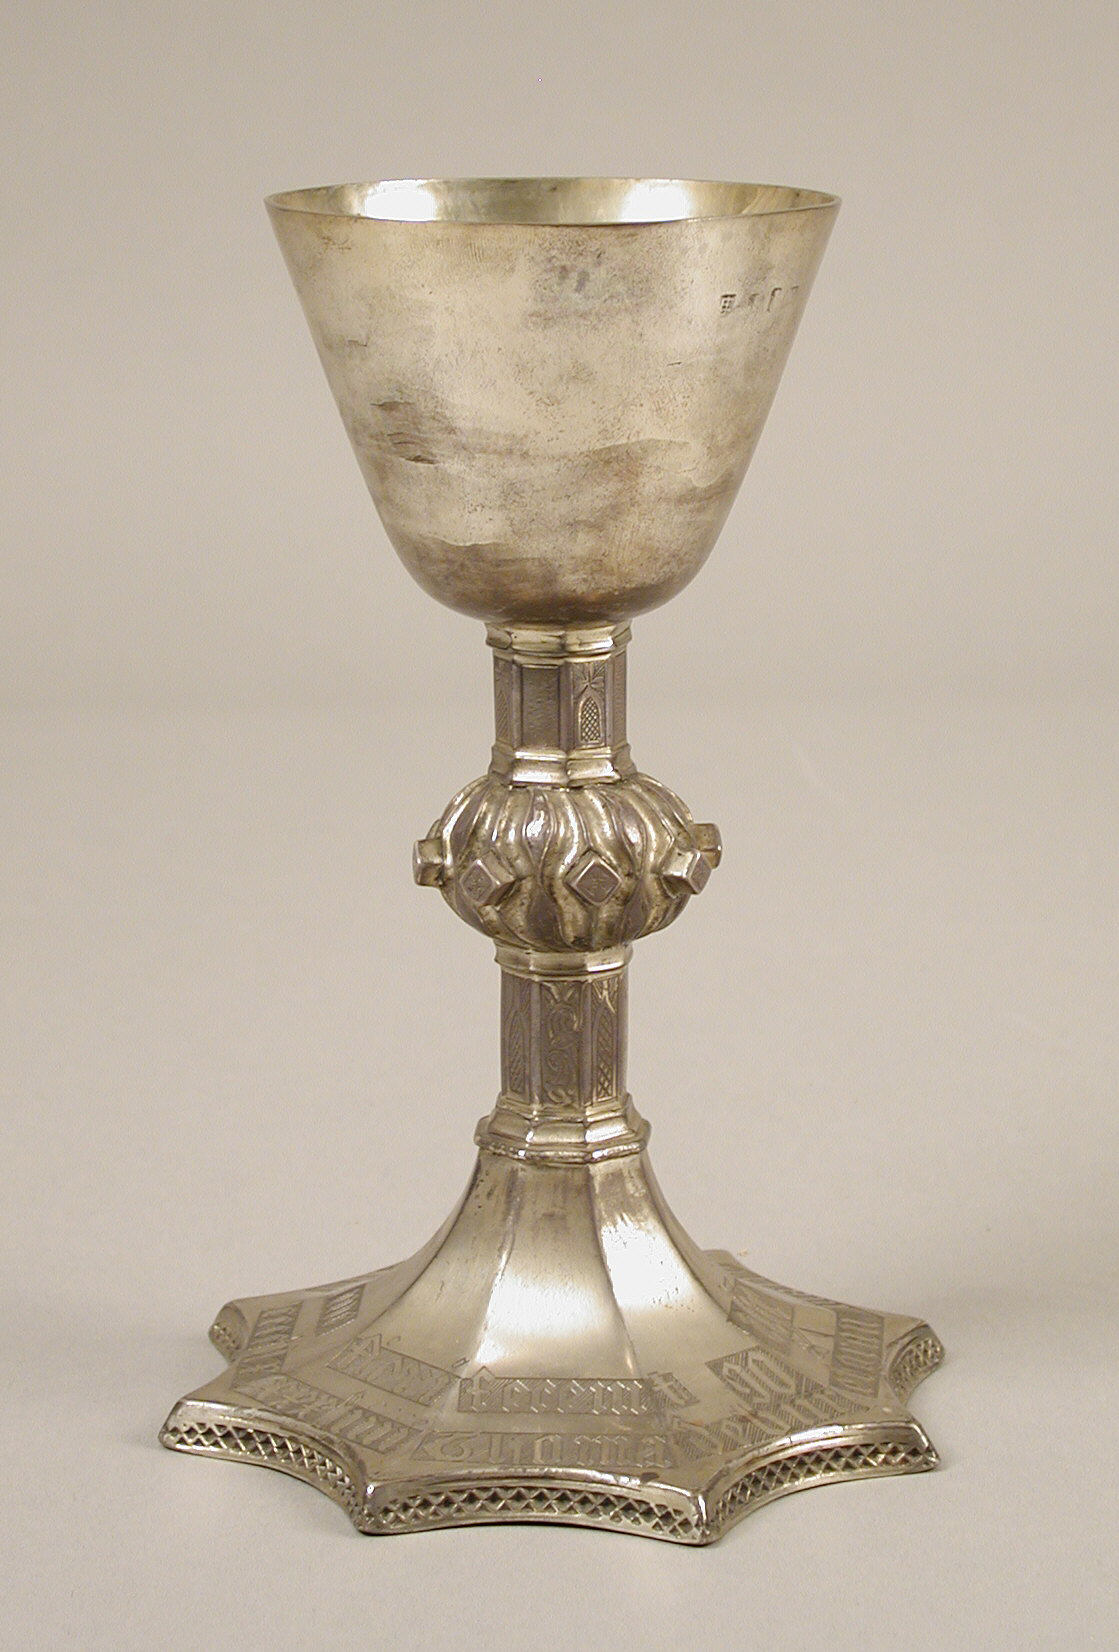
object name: chalice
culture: irish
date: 1901-1933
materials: silver gilt